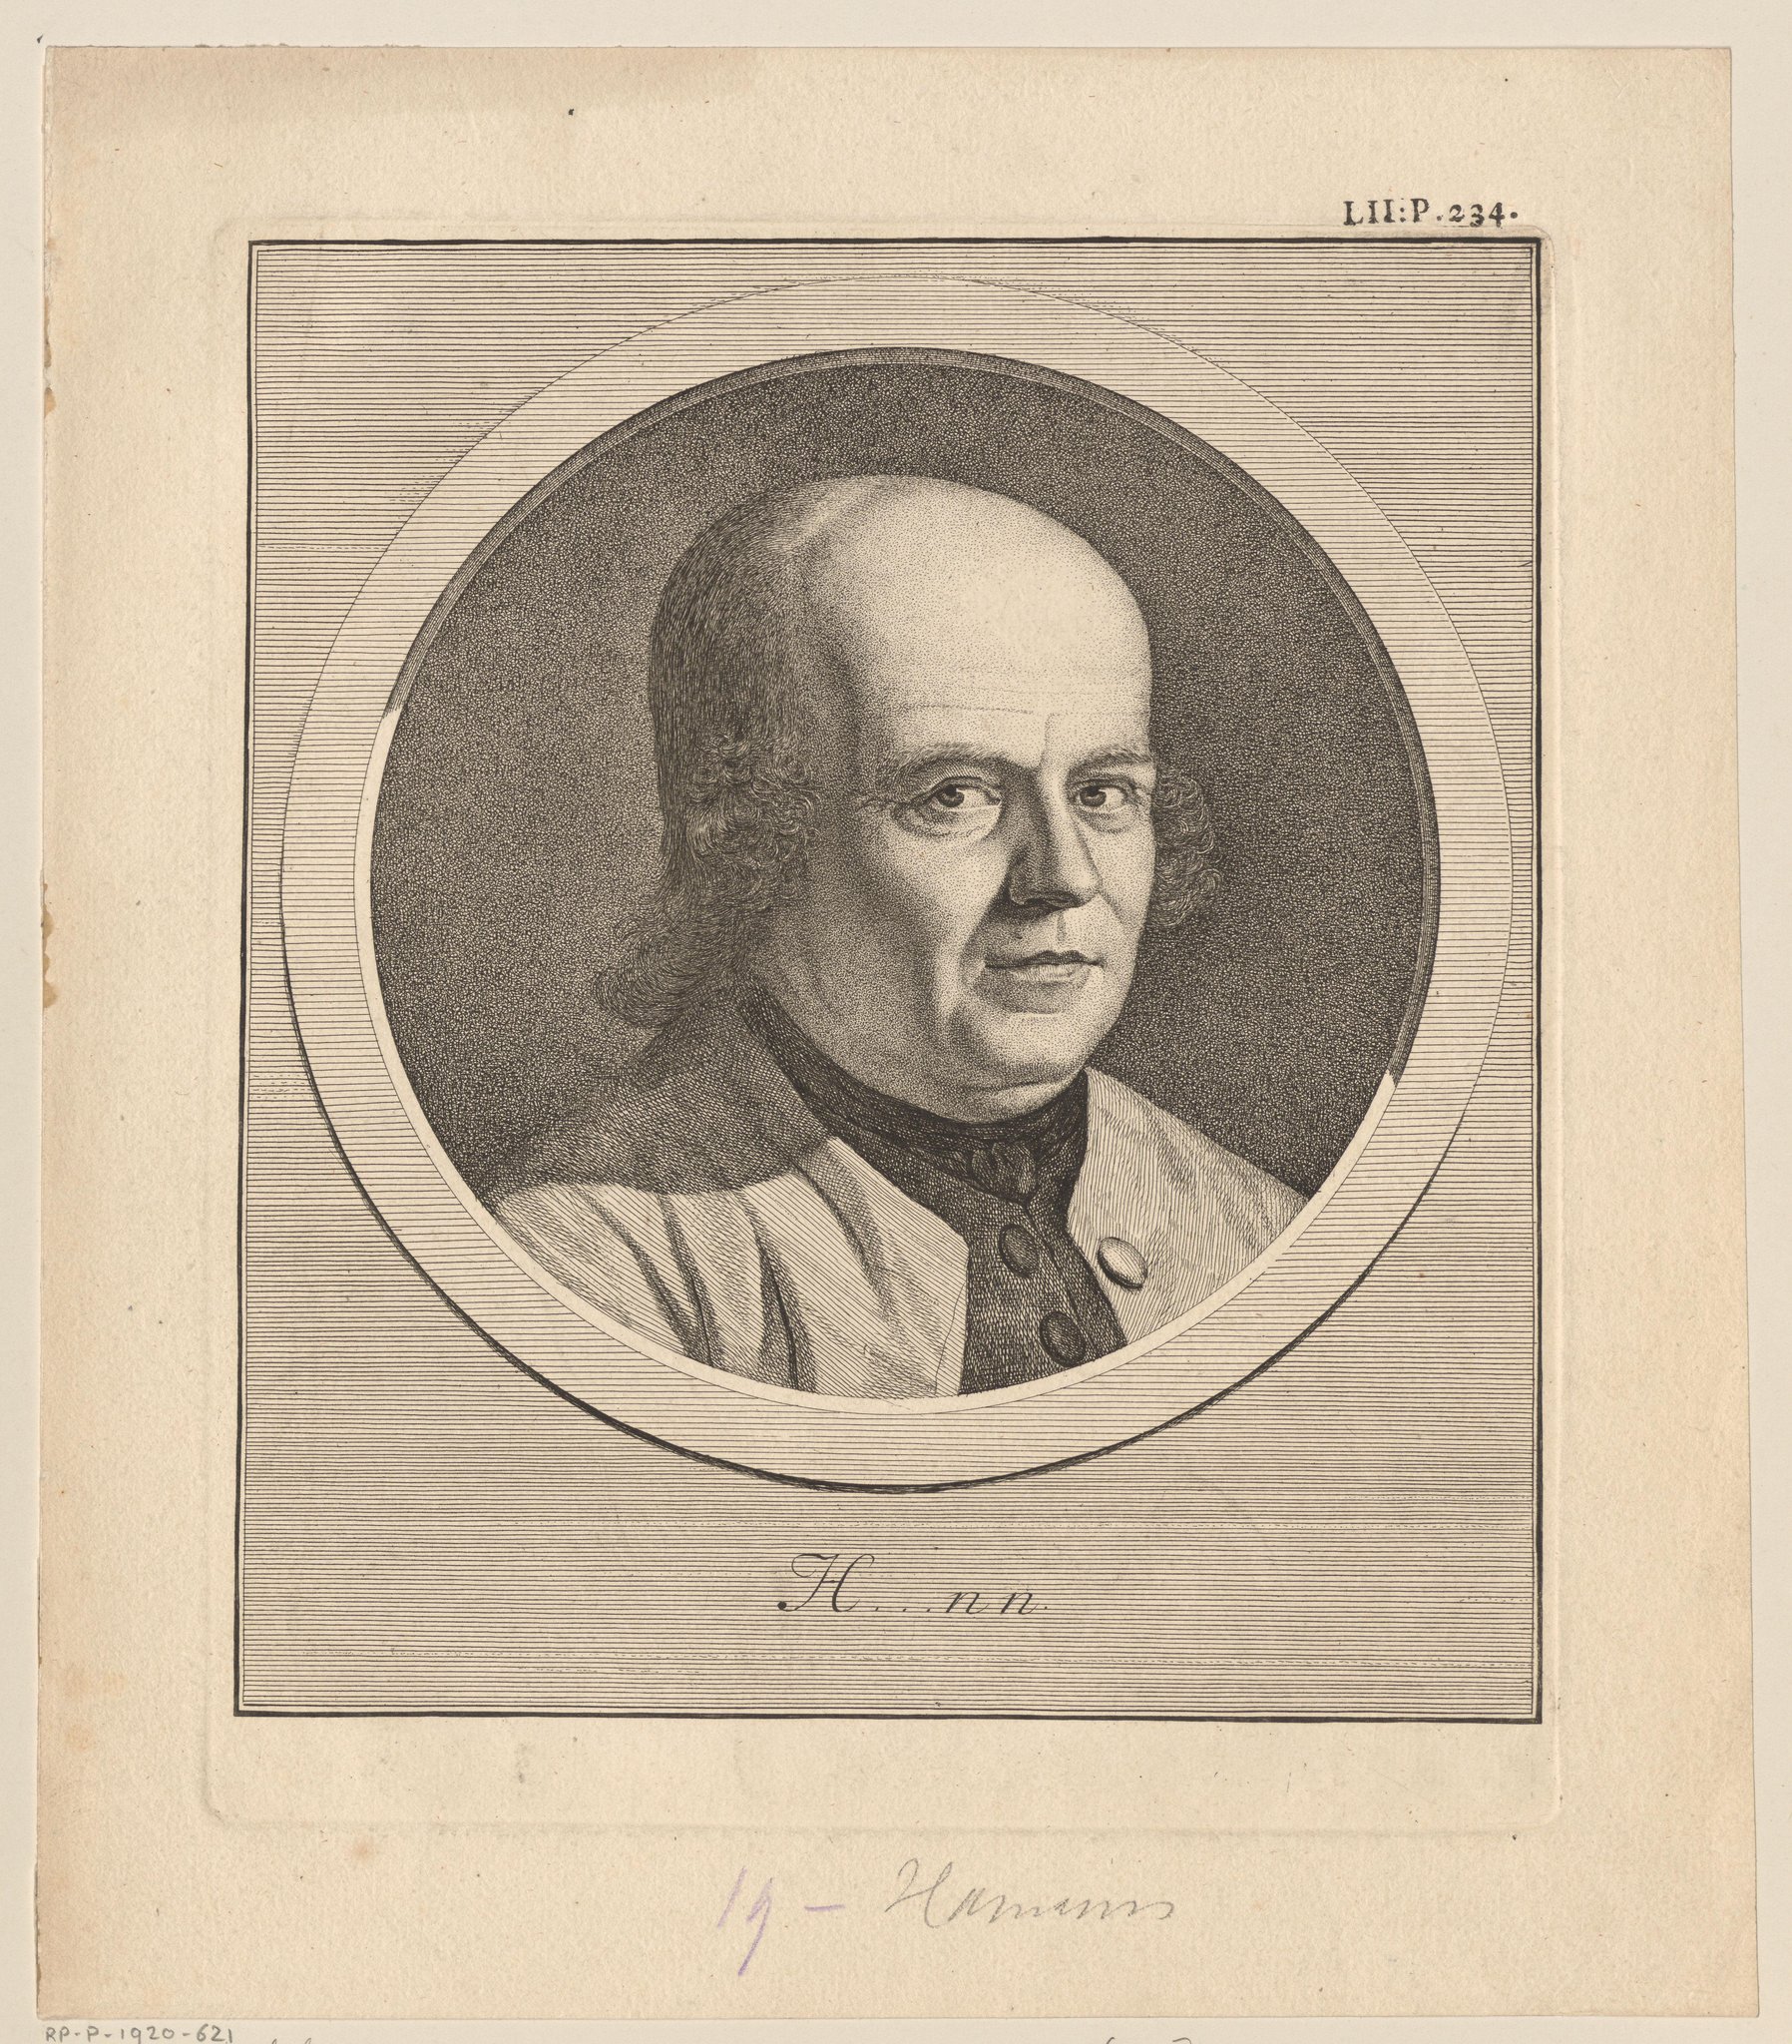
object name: print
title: Portret van een man, mogelijk Johann Georg Hamann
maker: Anonymous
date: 1750-1799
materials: paper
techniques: engraving, etching, letterpress printing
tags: scholar, philosopher, historical persons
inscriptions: collector's mark: Lugt 2228